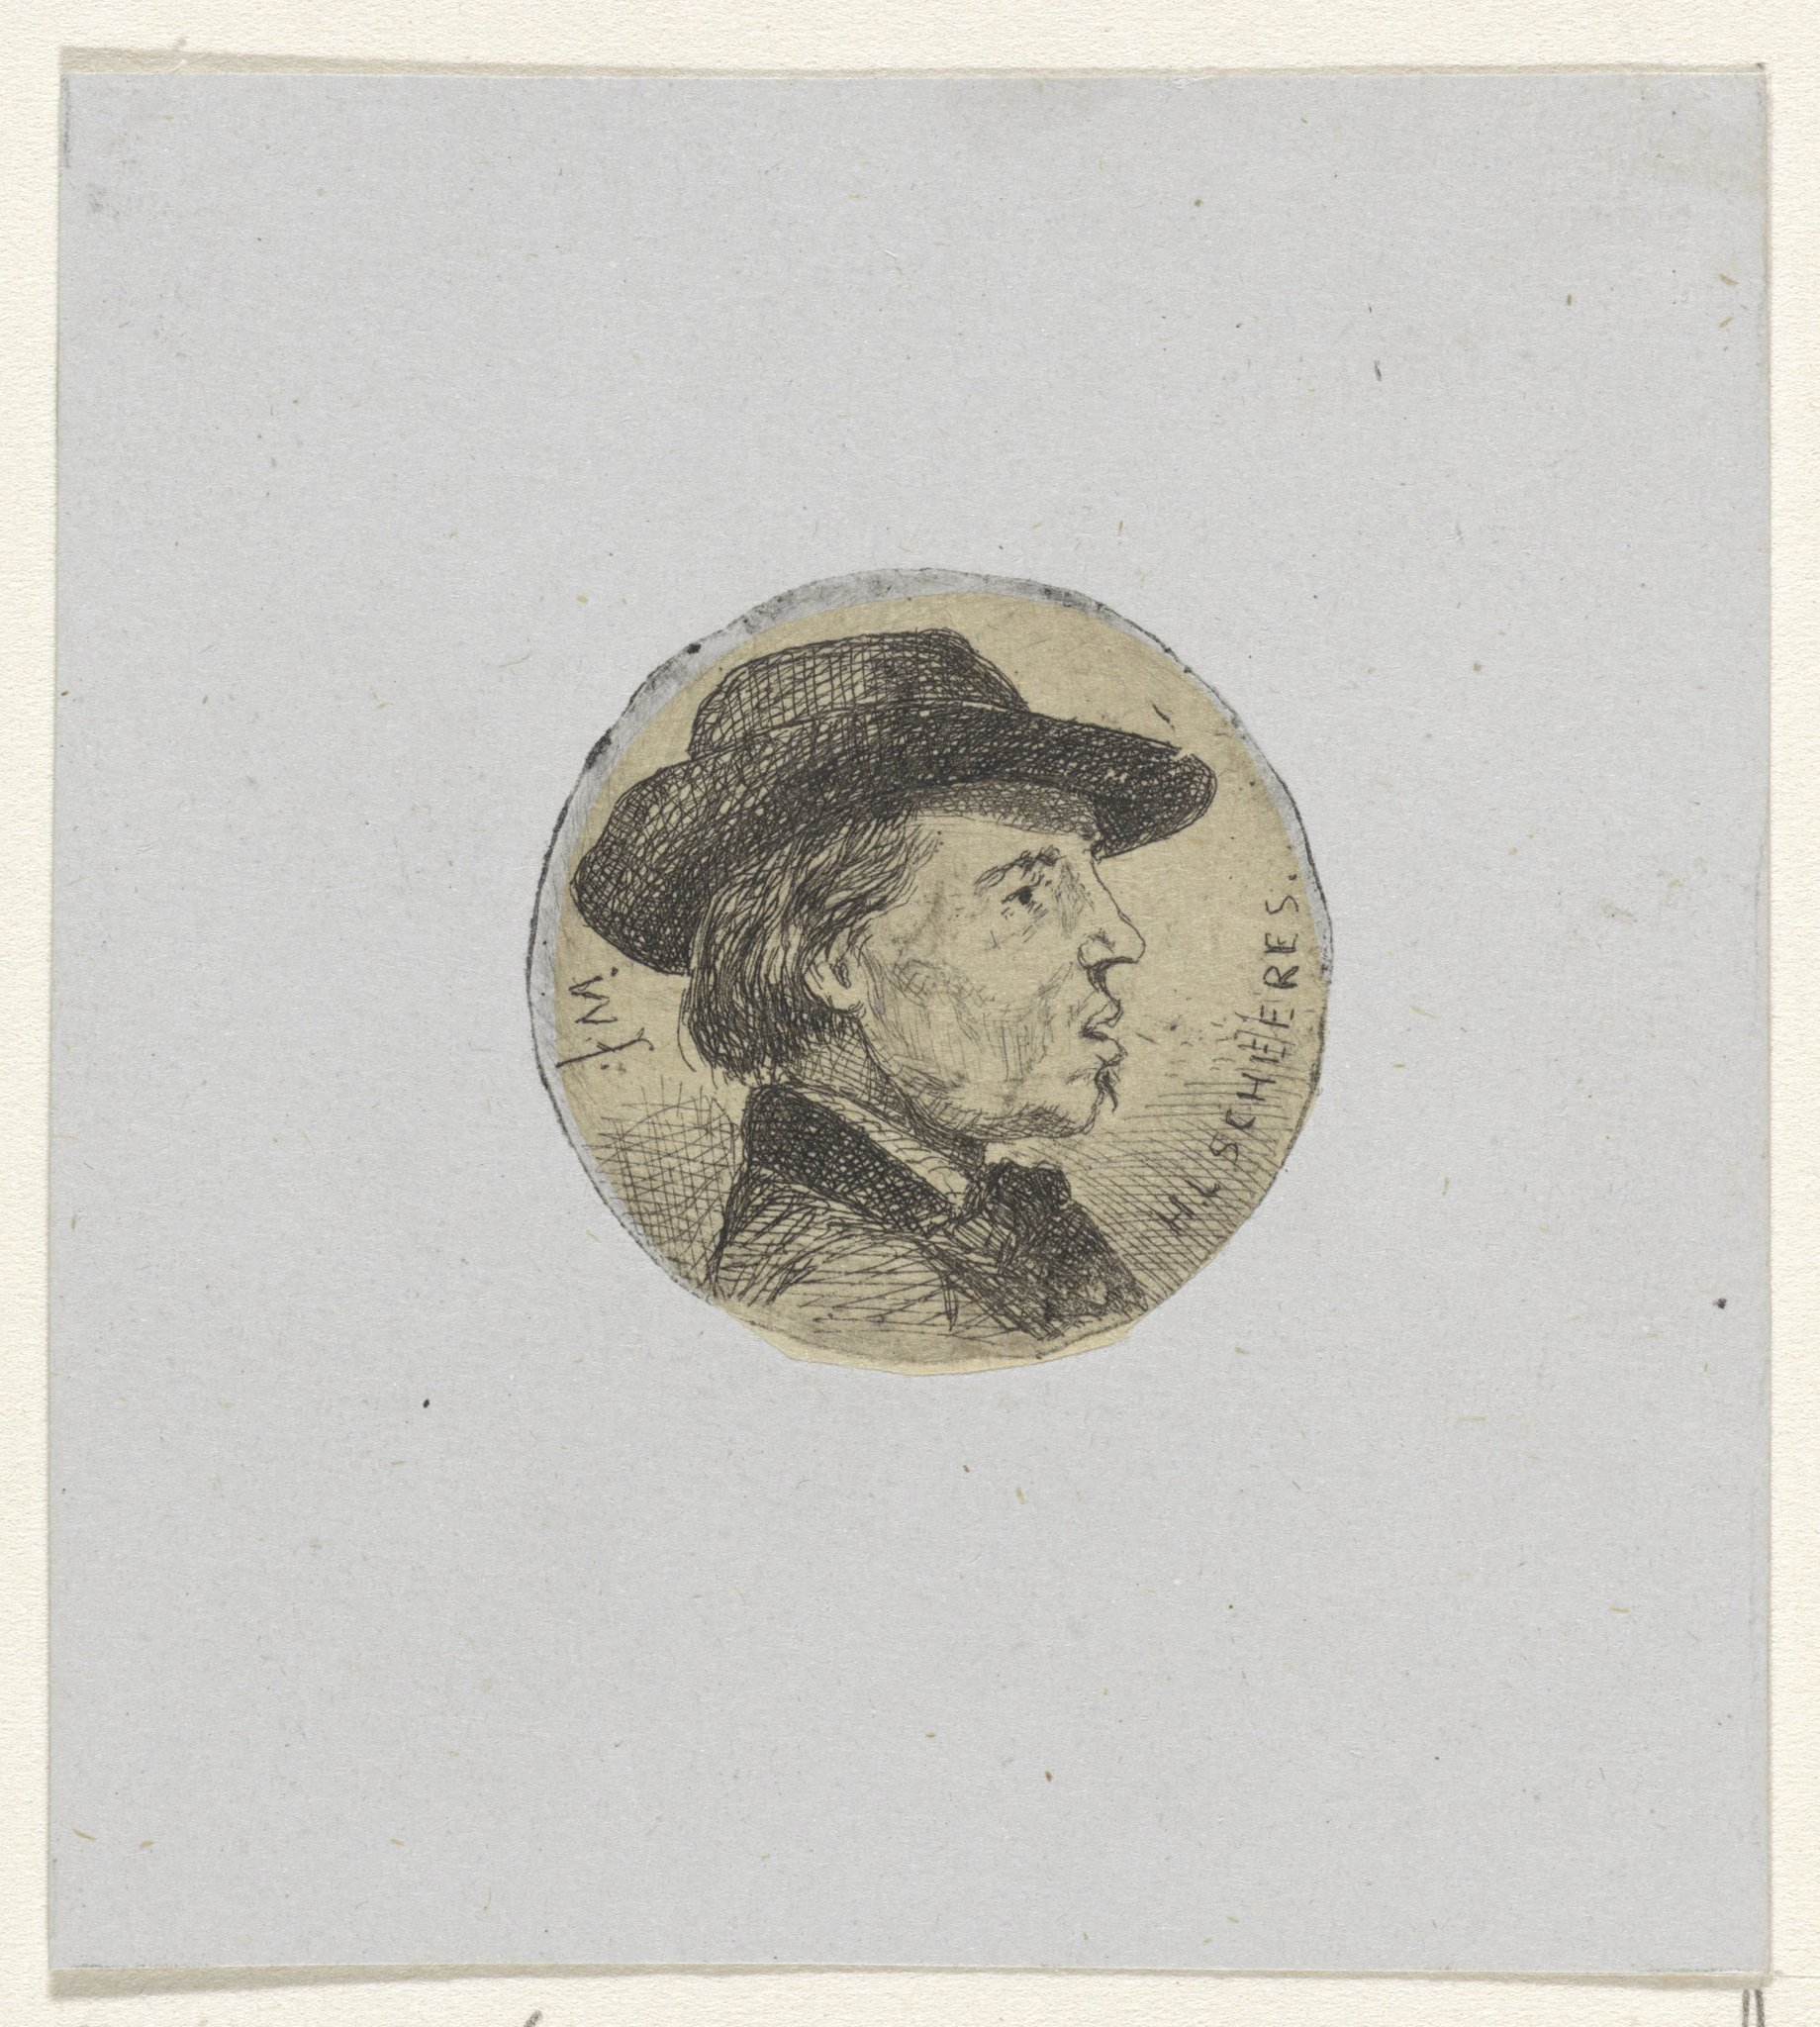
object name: print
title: Portret van Hendricus Johannes Scheeres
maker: jan weissenbruch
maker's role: painter, print maker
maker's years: 1822-1880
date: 1837-1864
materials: paper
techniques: etching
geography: the hague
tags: the hague, hendricus johannes scheeres, historical persons, head-gear: hat (+ men's clothes), portrait, self-portrait of artist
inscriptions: collector's mark: Lugt 2228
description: Portret van Hendricus Johannes Scheeres, kunstenaar. Hij draagt een hoed. Rechts onderin is de naam van de geportretteerde weergegeven.